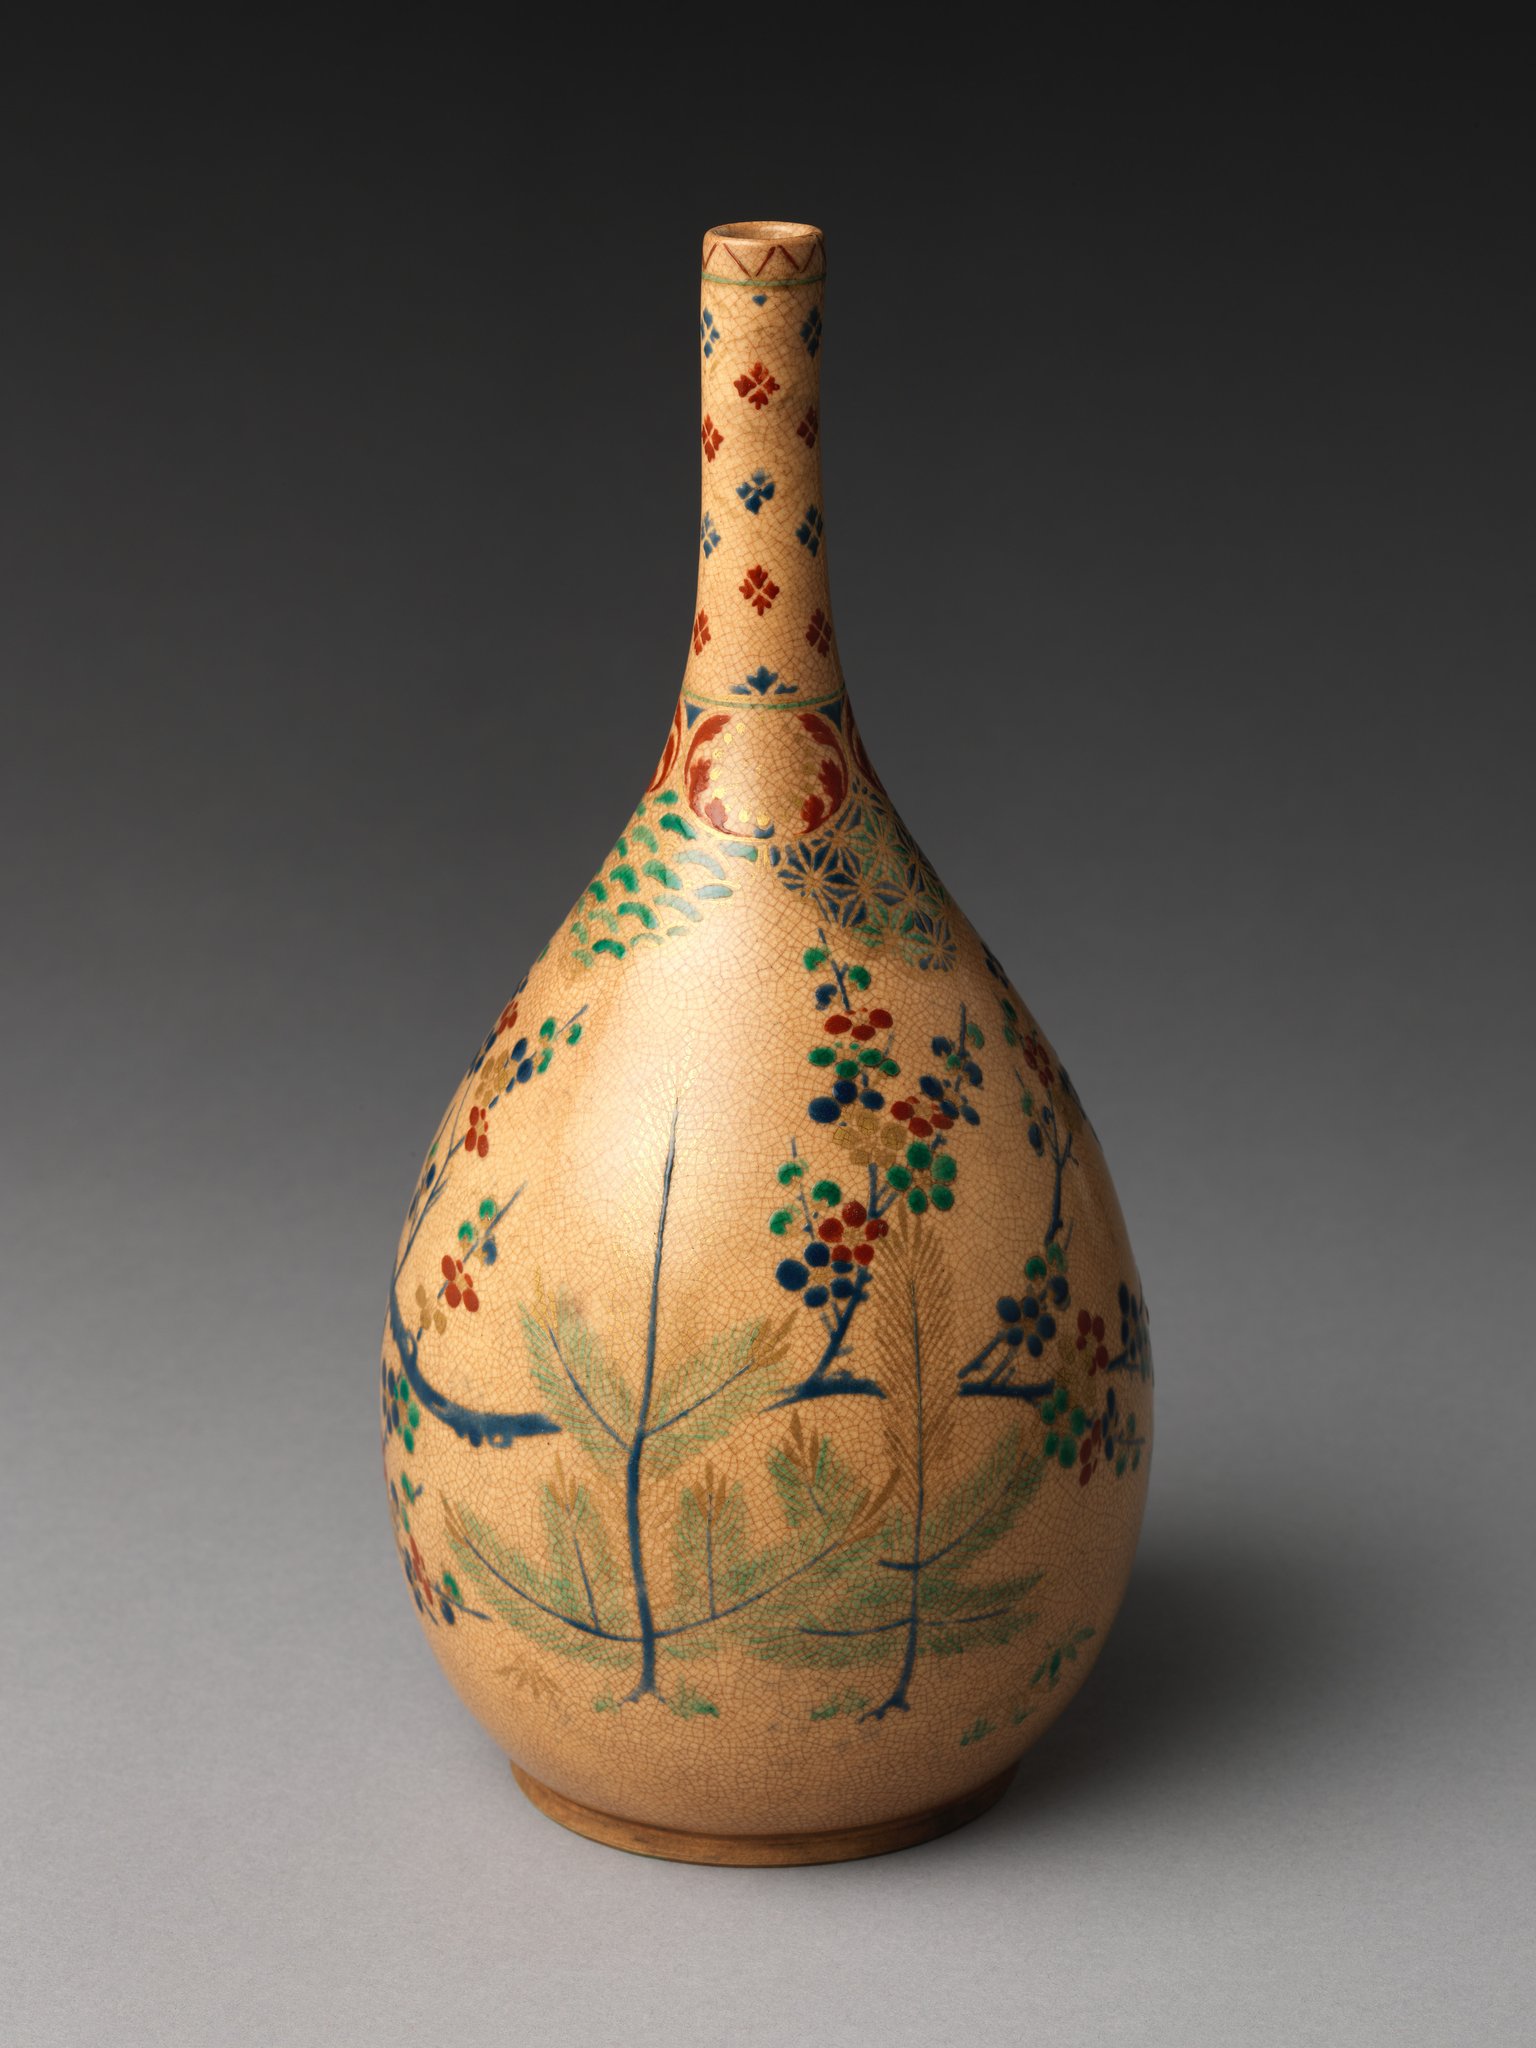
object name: sake bottle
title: Sake bottle with pine and plum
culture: japanese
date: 1701-1800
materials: stoneware